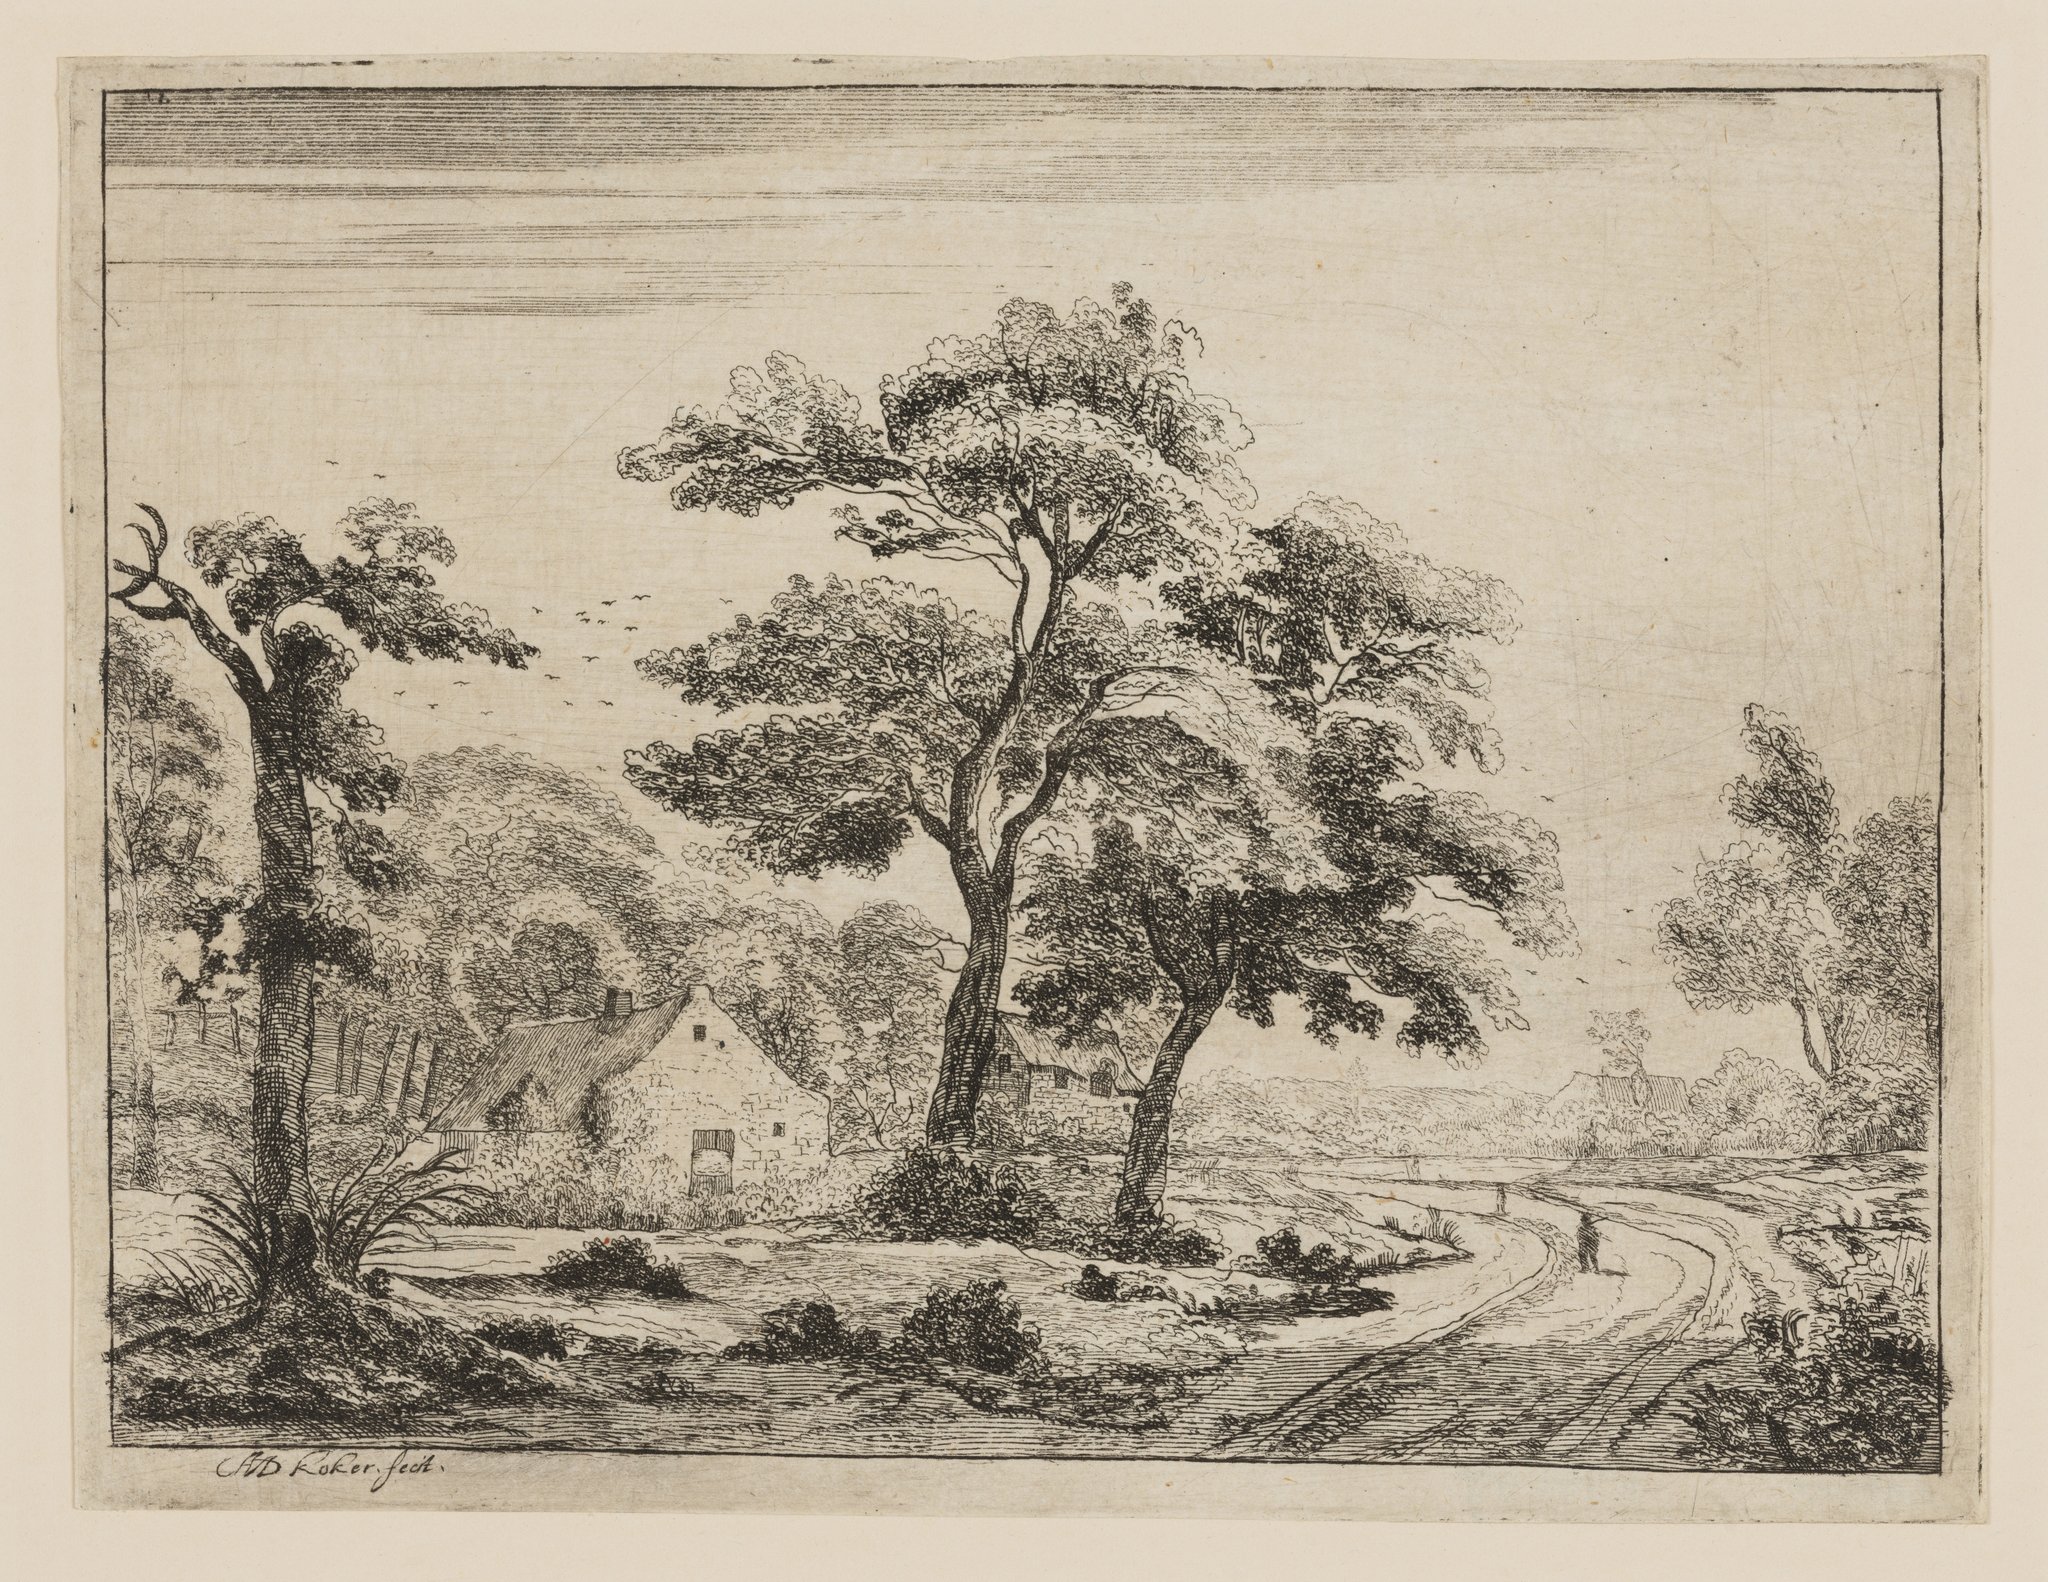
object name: print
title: The Road to the Village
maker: anna-maria de koker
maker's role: artist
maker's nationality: netherlandish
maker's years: -1698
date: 1698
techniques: etching